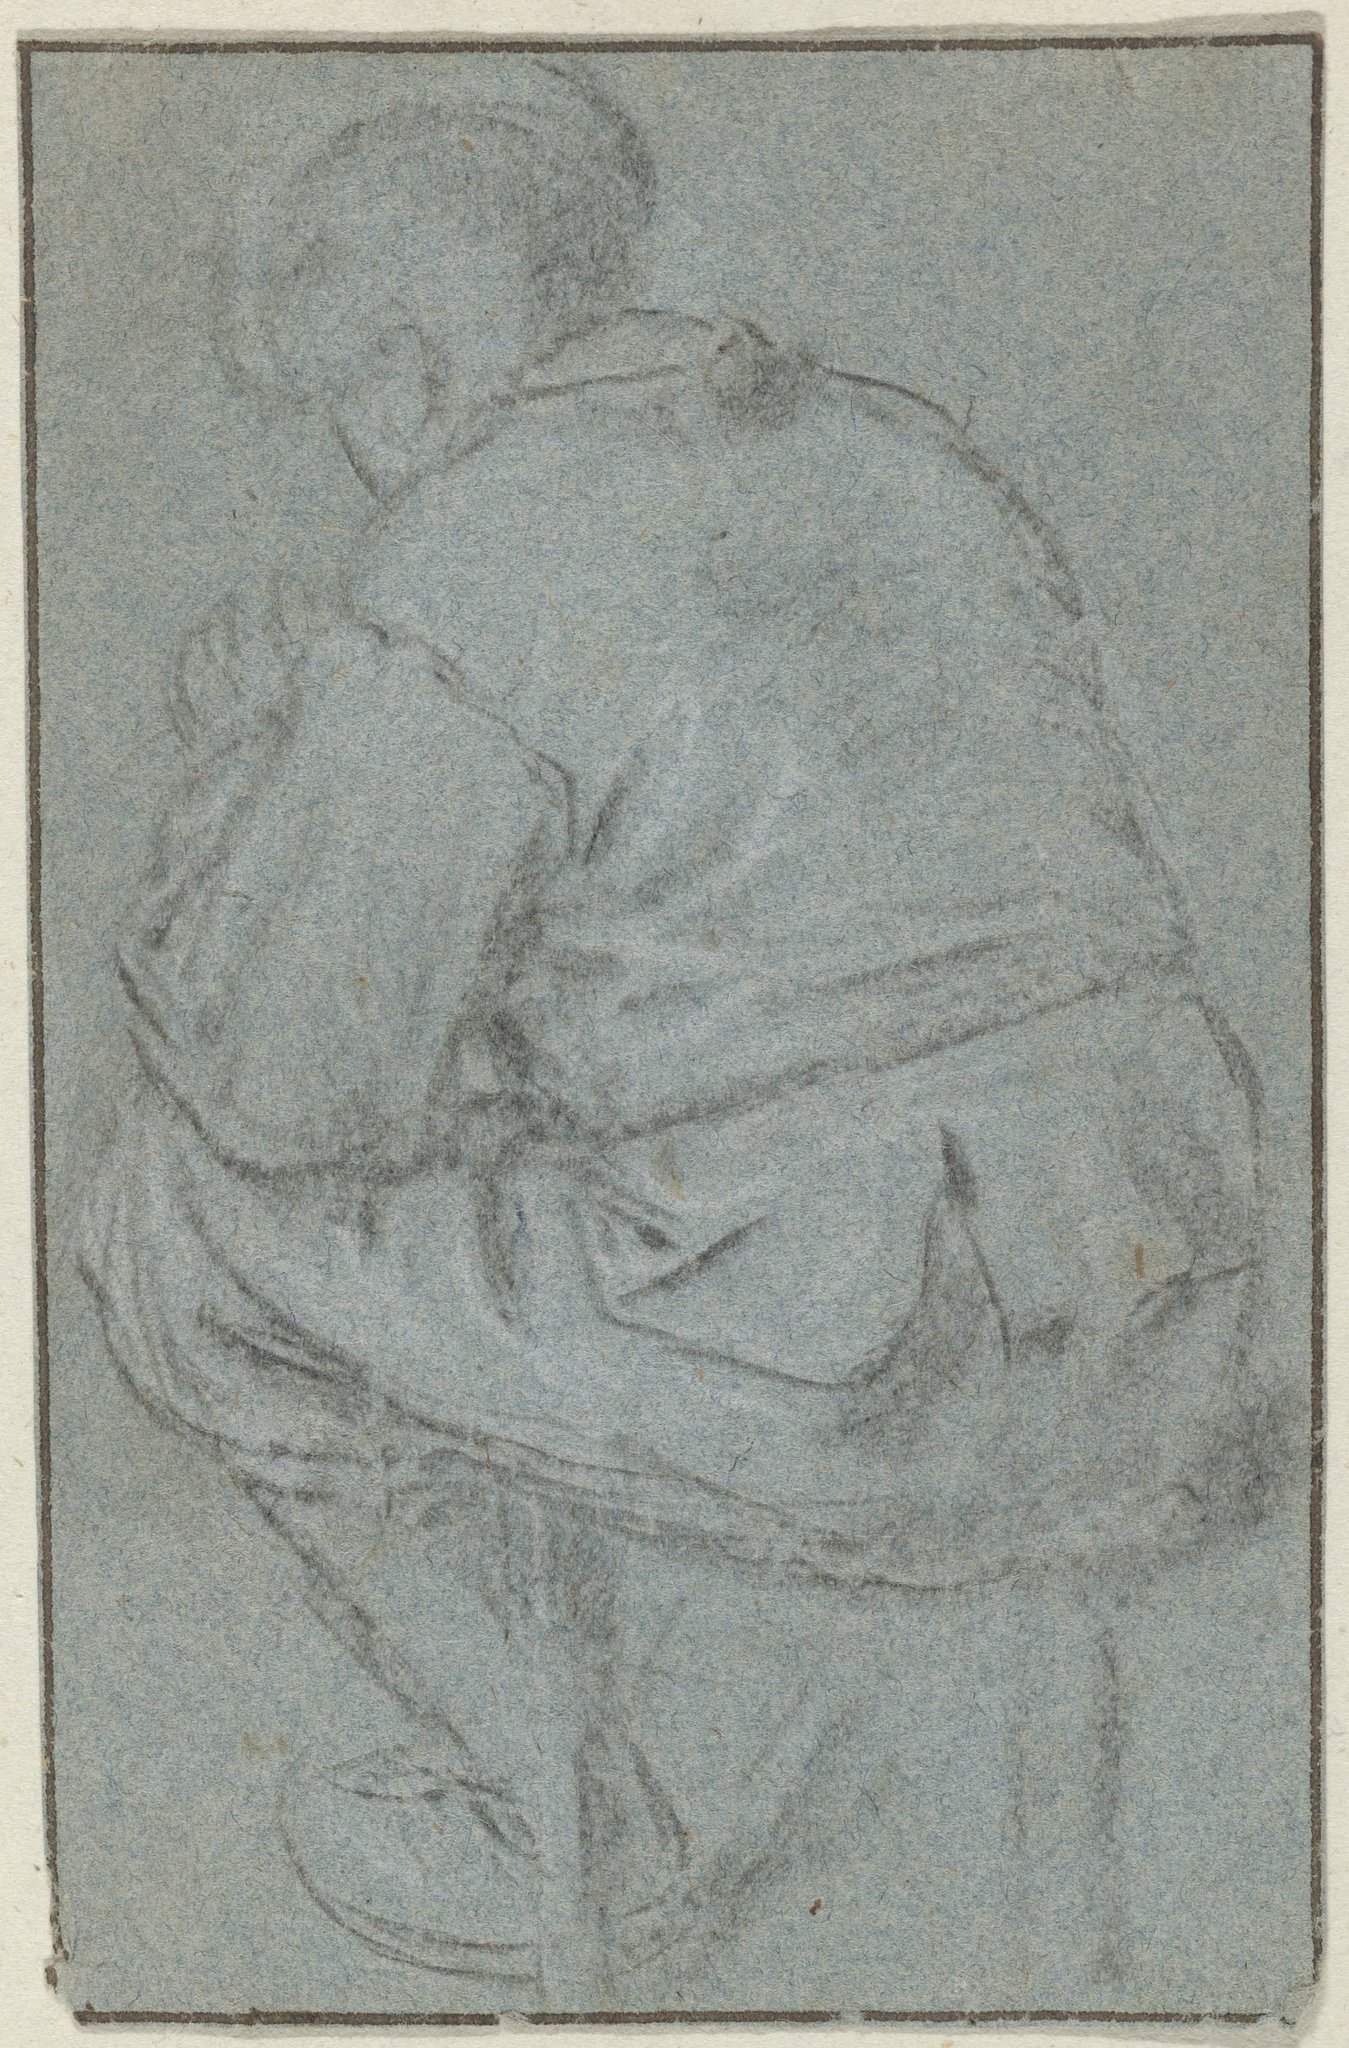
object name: drawing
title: Op kruk zittende man, op de rug gezien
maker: Anonymous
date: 1600-1699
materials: chalk, paper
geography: netherlands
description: Verso sporen van zwart krijt gehoogd met wit krijt.